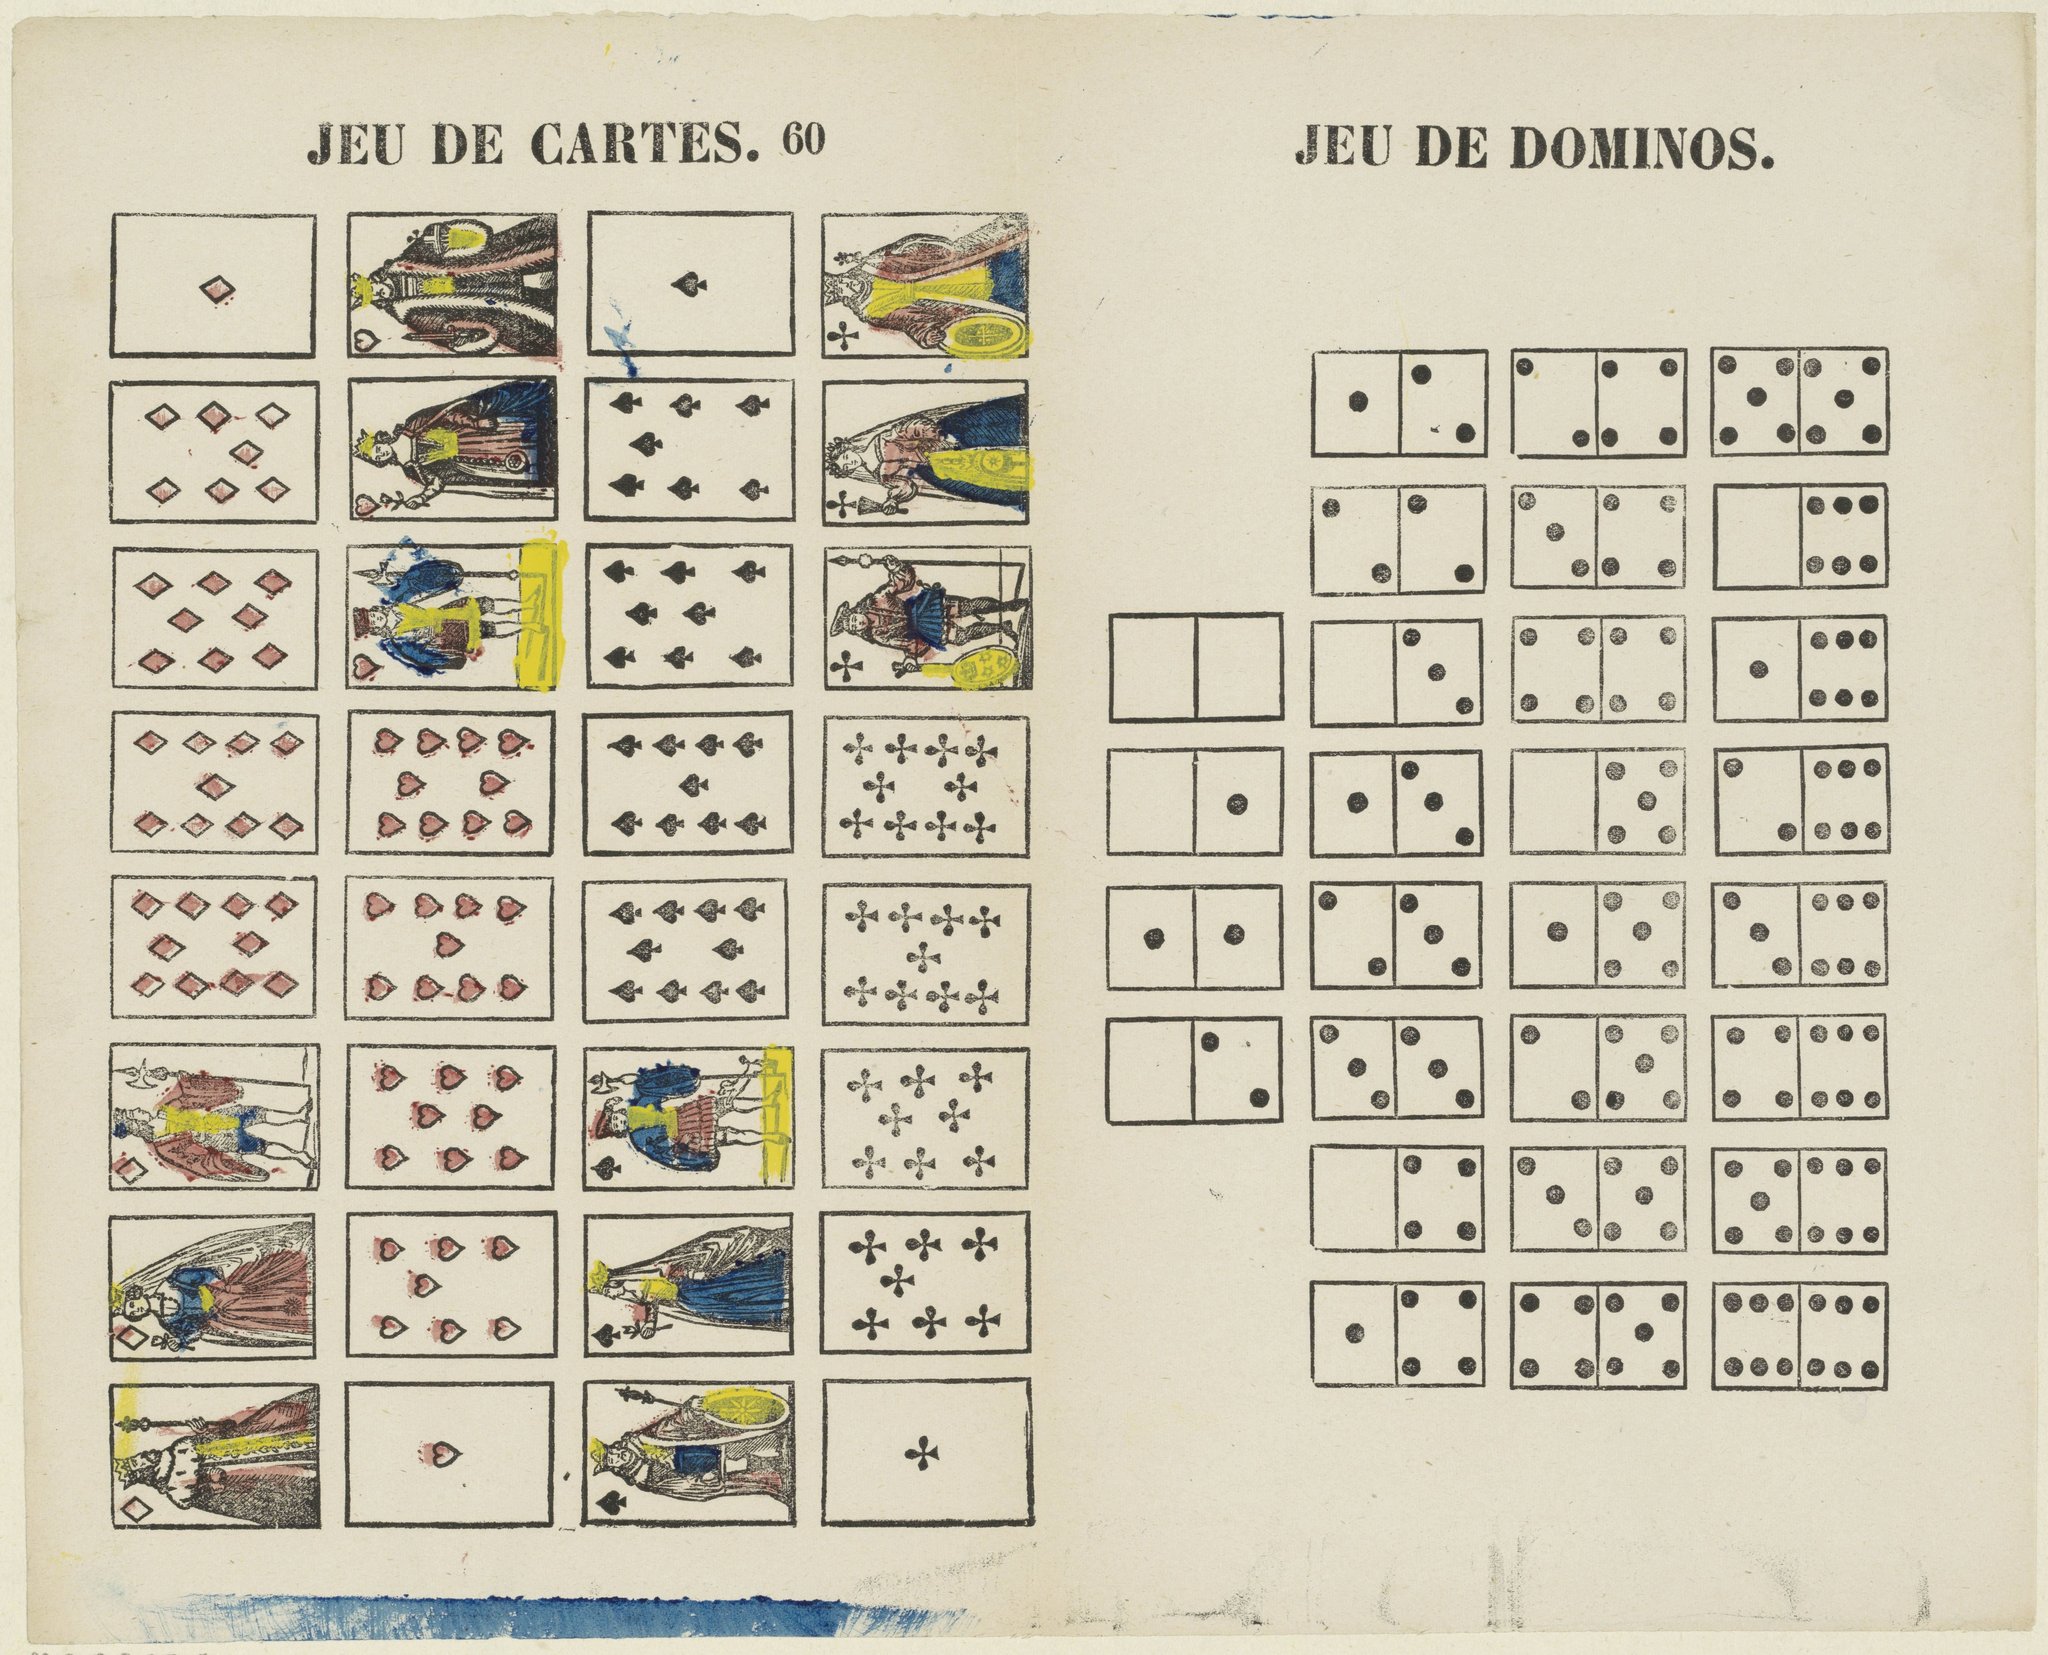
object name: card game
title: Jeu de cartes / Jeu de dominos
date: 1827-1894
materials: paper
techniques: colour, letterpress printing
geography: schaarbeek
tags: dominoes, playing-cards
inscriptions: collector's mark: Lugt 2760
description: Blad met 32 speelkaarten en 28 dominostenen om uit te knippen. Genummerd midden boven: 60.